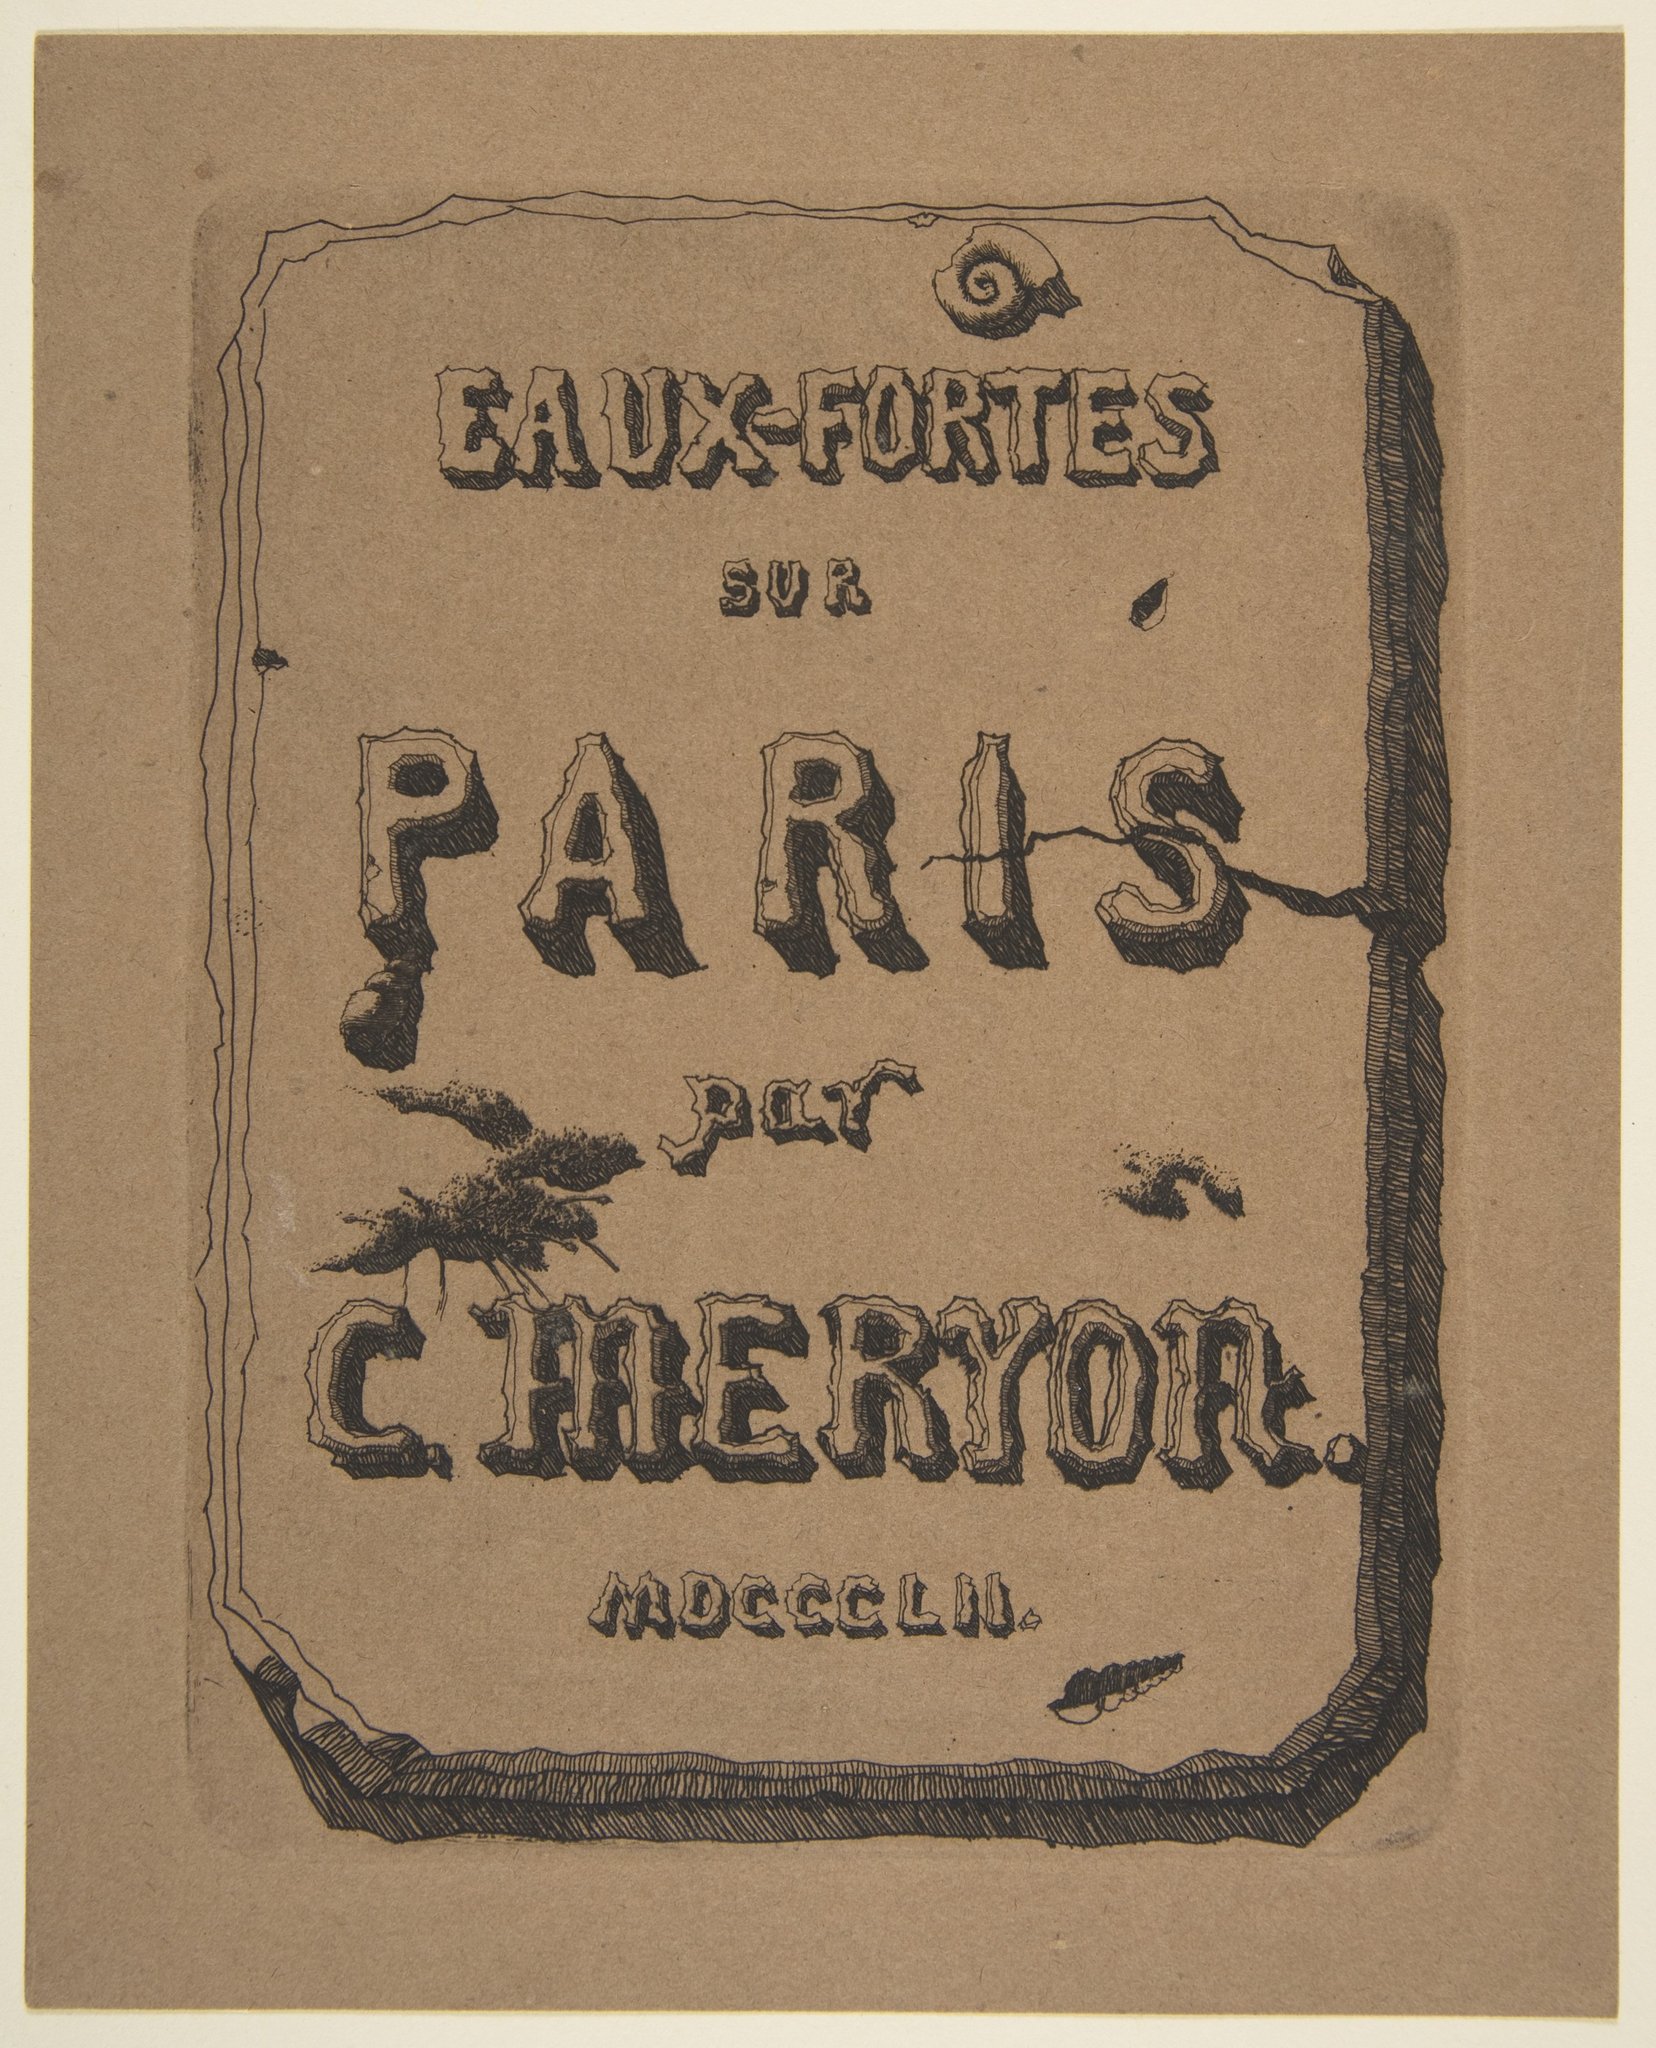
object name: print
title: Etchings of Paris; Title page to the suite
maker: charles meryon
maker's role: artist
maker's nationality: french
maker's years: 1821-1868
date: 1852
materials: paper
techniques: etching